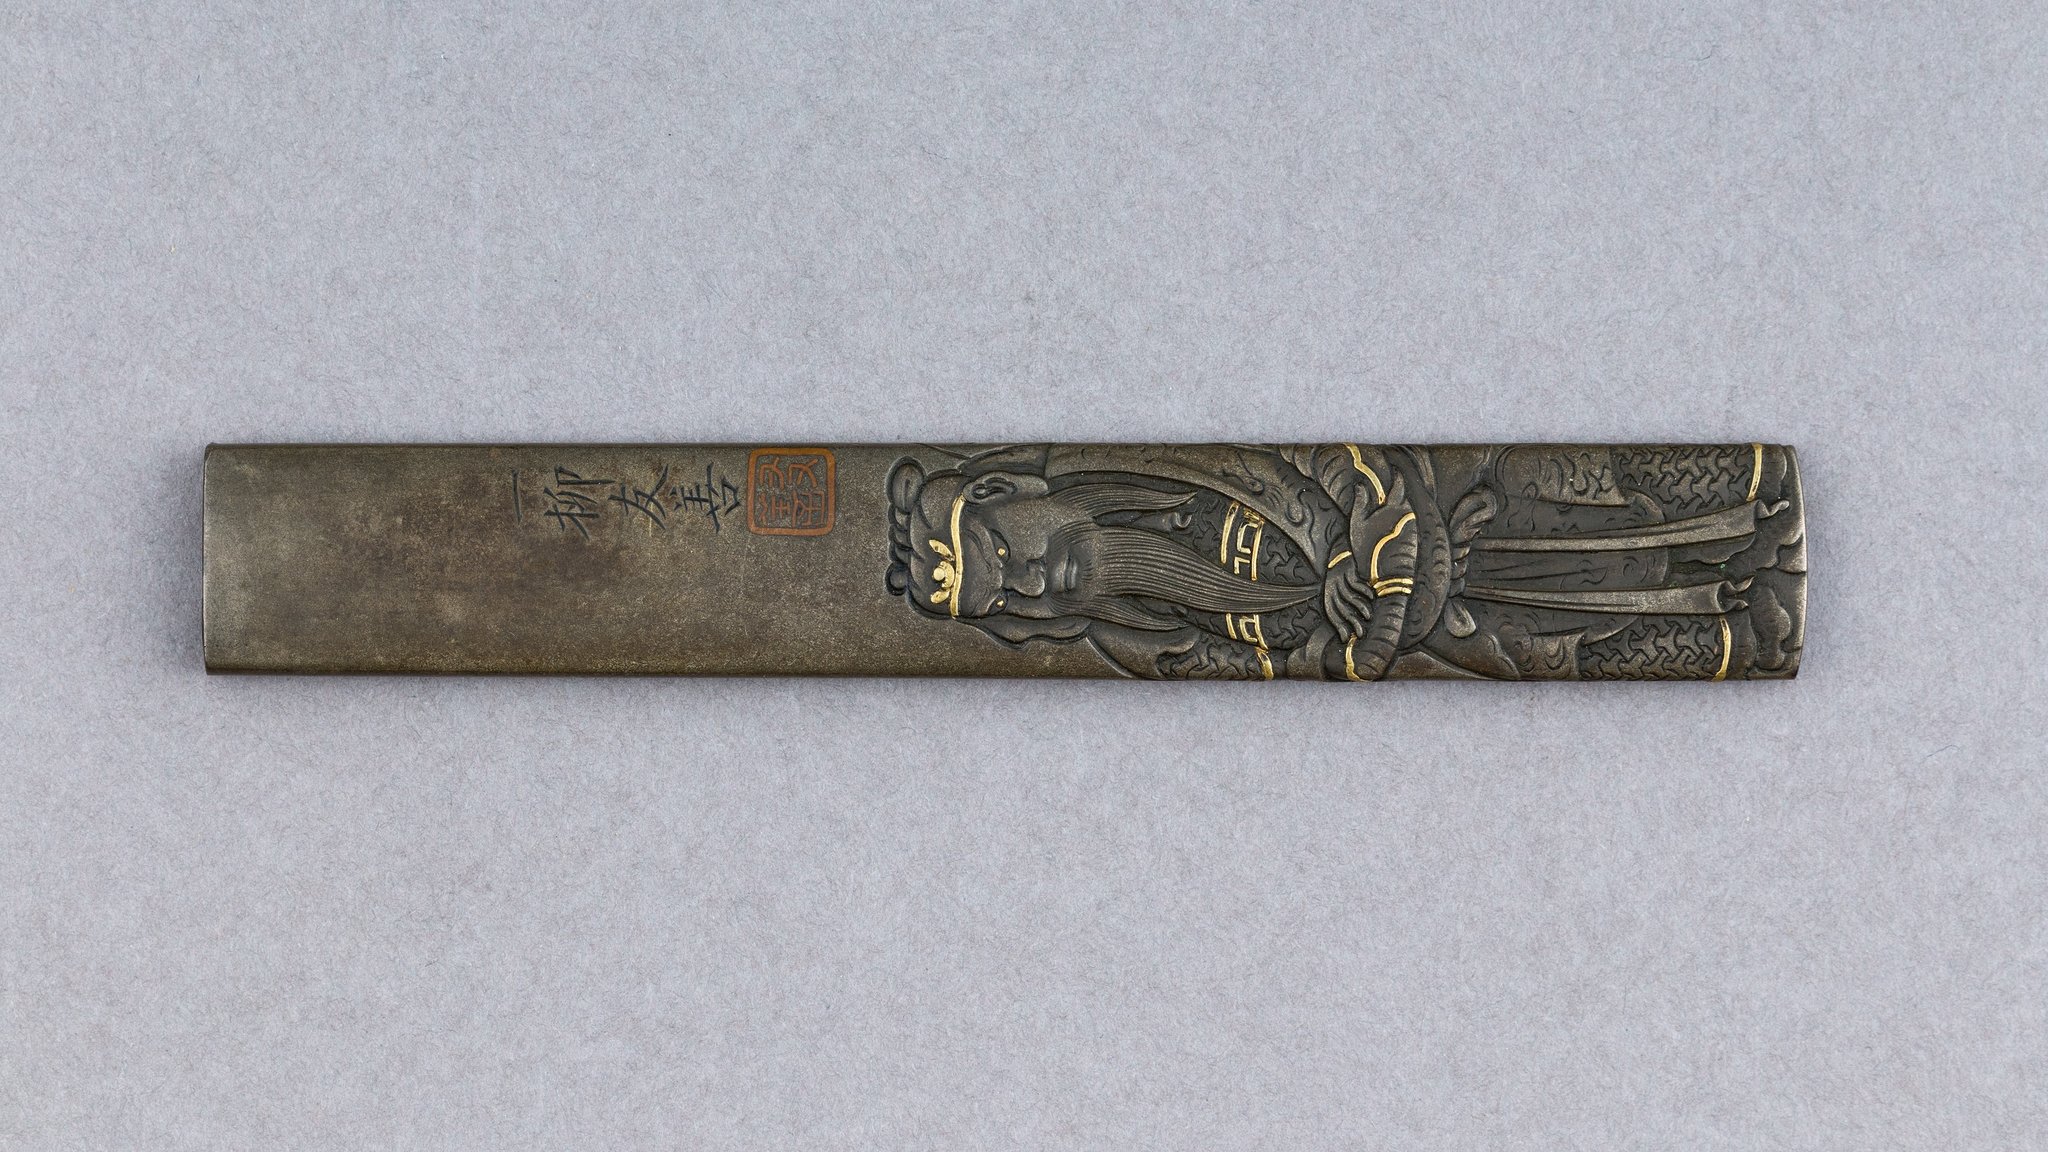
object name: knife handle kozuka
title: Knife Handle (Kozuka)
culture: japanese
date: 1615-1868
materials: silver alloy, gold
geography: japan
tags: men